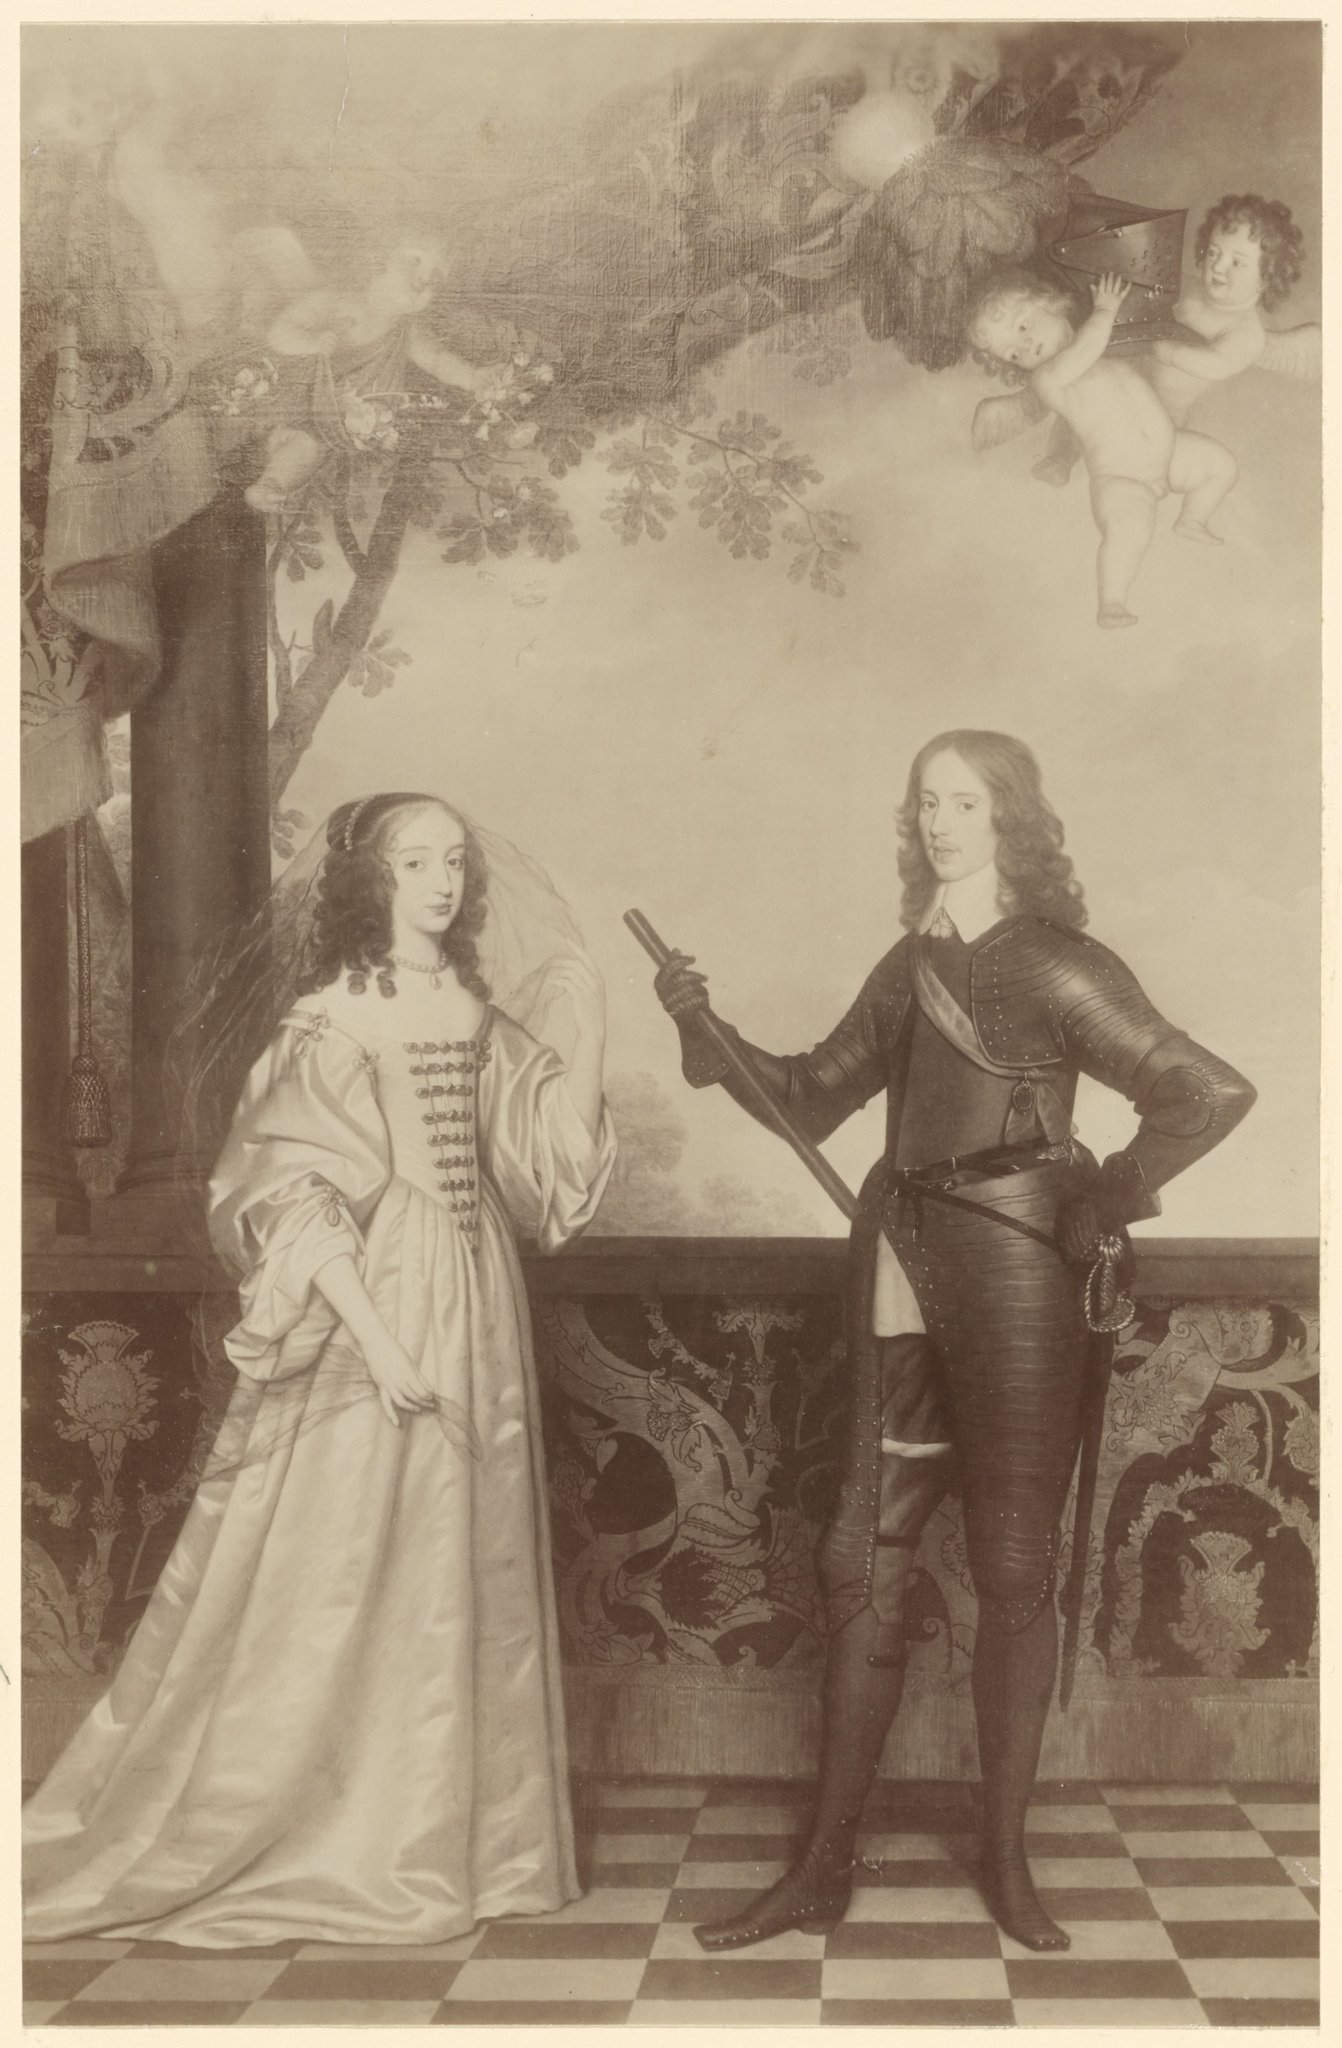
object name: photograph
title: Portret van Willem II, prins van Oranje, en Maria Henrietta Stuart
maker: Anonymous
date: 1850-1930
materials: photographic support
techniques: photography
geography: netherlands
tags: william ii (prince of orange), mary henrietta stuart